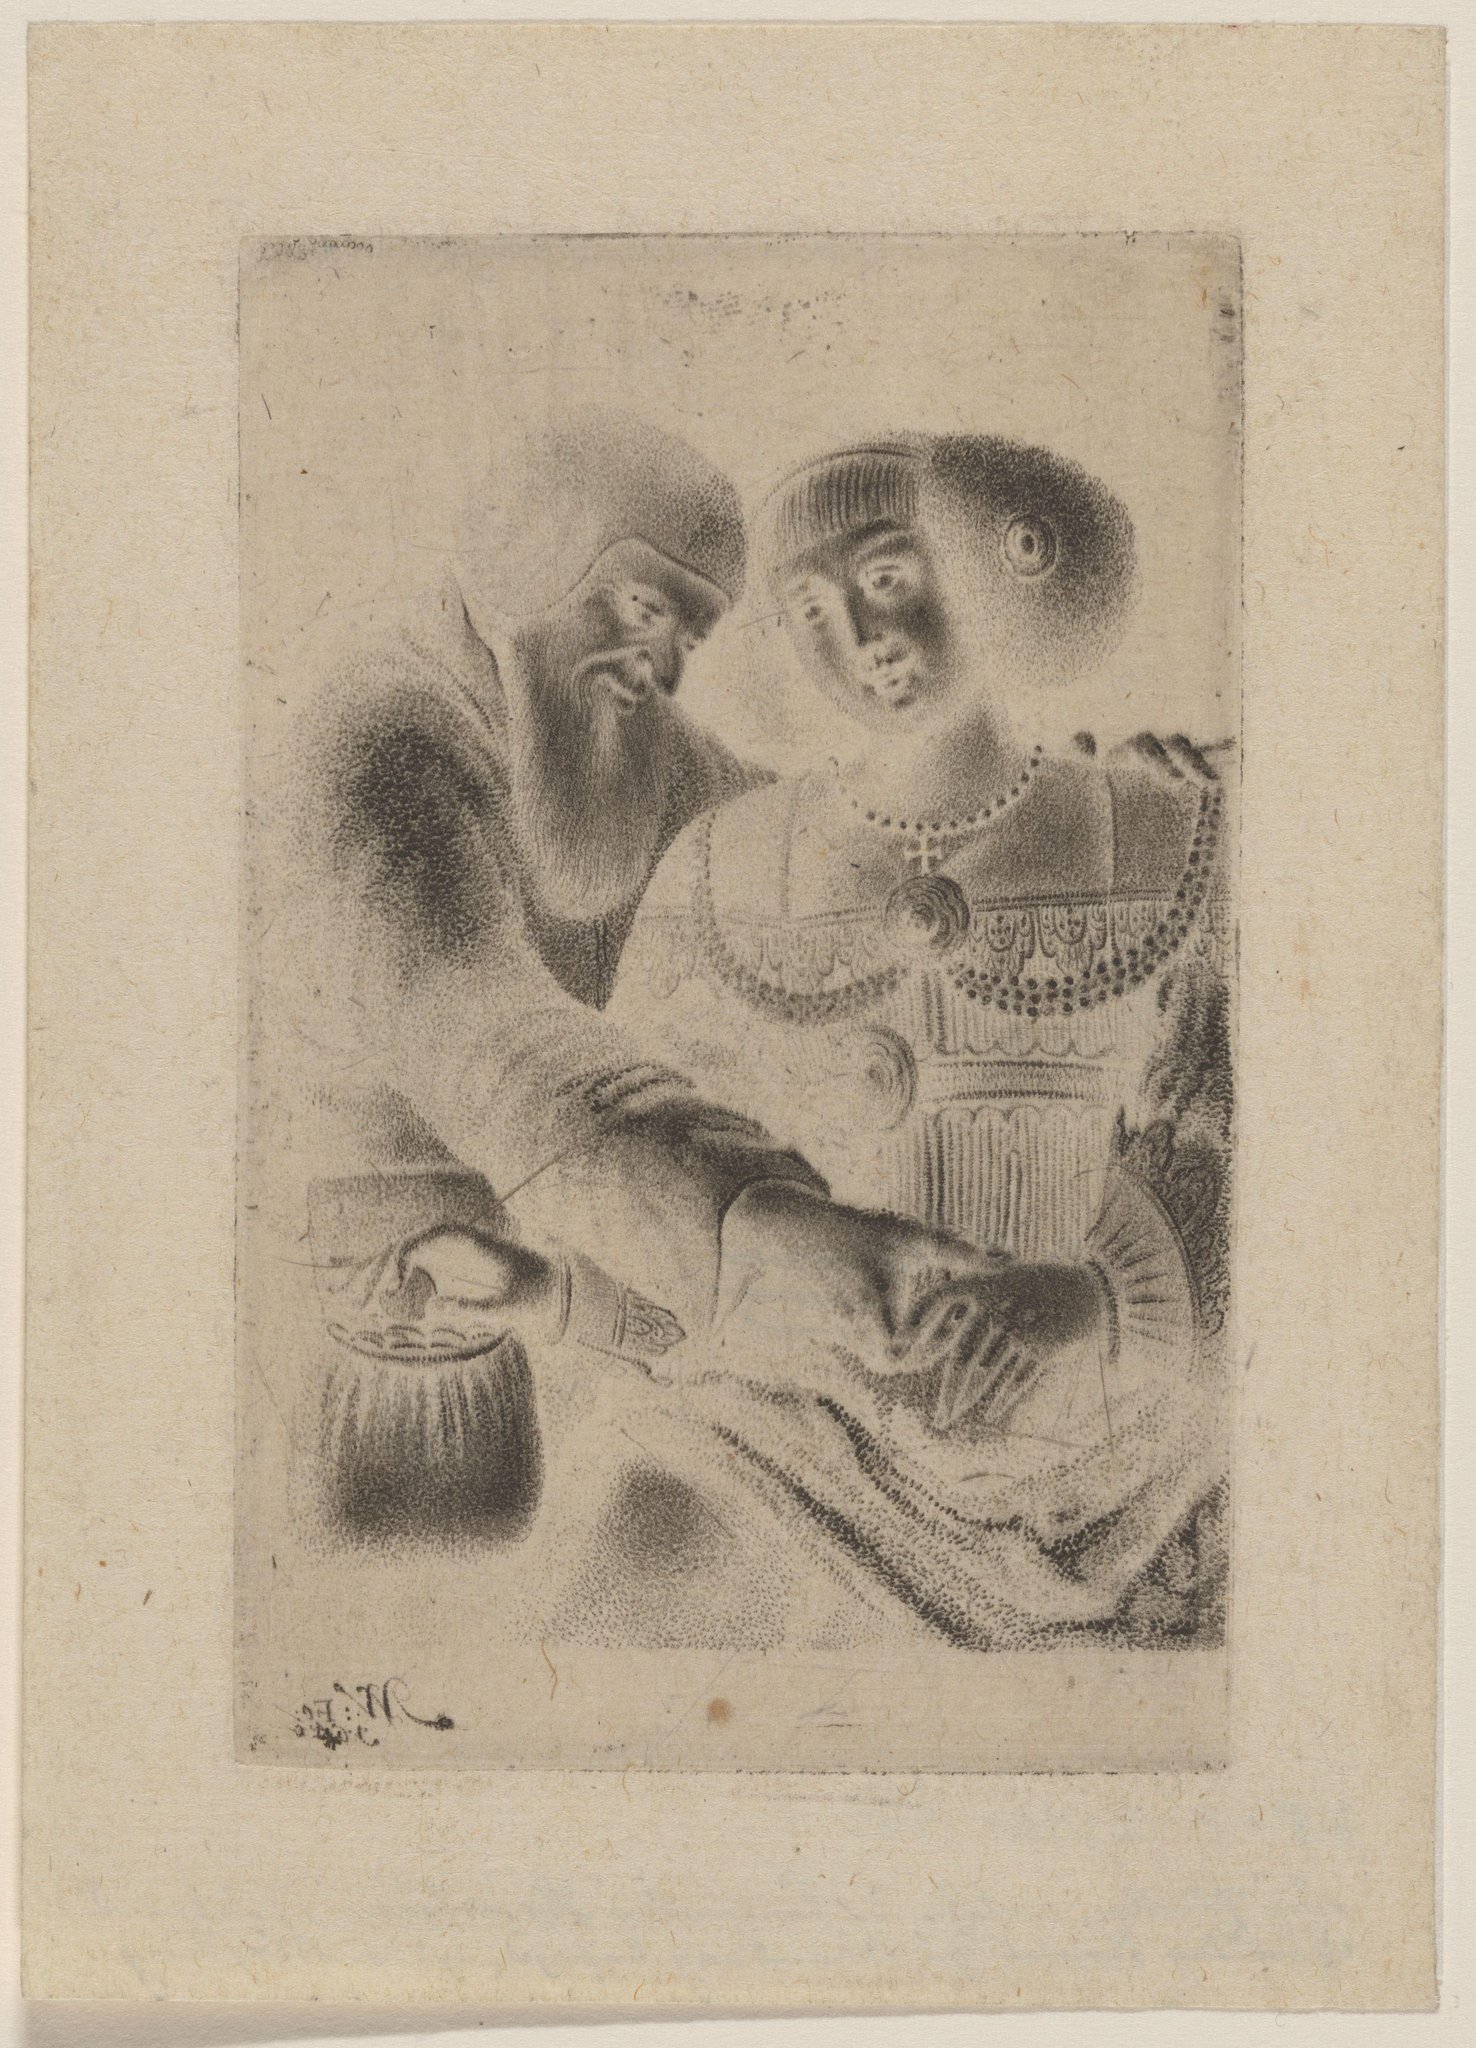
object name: print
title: Unequal love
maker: meester nw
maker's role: print maker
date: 1640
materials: paper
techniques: punched engraving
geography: germany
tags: married couple of unequal age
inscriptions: collector's mark: Lugt 2228, collector's mark: Lugt 2760, name: ‘Johann Andreas Boerner, Neurenberg’ Lugt 269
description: While the older man embraces her, the woman secretly takes a coin from his purse. This theme, a caution against unequal love, was popular in the 17th century. The print was made in a stipple technique used by silversmiths. Passages of light and shadow seem to be reversed, as in a photo negative. Because of the subtle transitions between light and dark, the image looks almost three-dimensional.